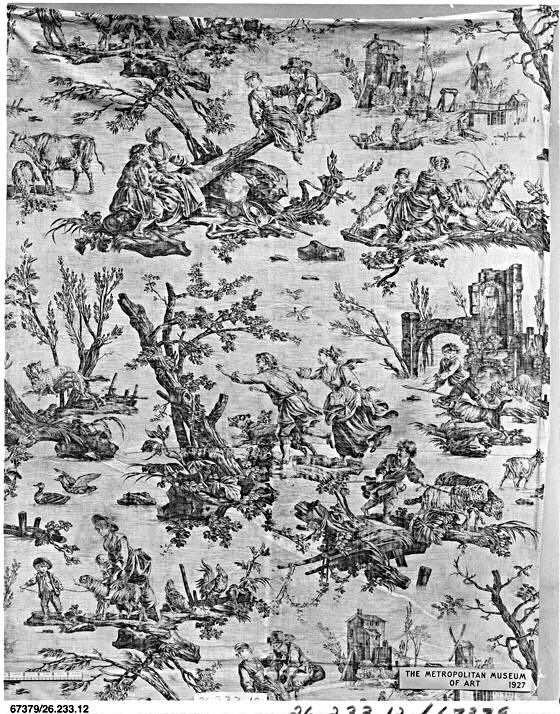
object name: furnishing textile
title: Pictorial print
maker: oberkampf manufactory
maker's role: manufactory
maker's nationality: french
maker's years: 1760-1843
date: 1785-1790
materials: linen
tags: animals,birds,men,women,trees